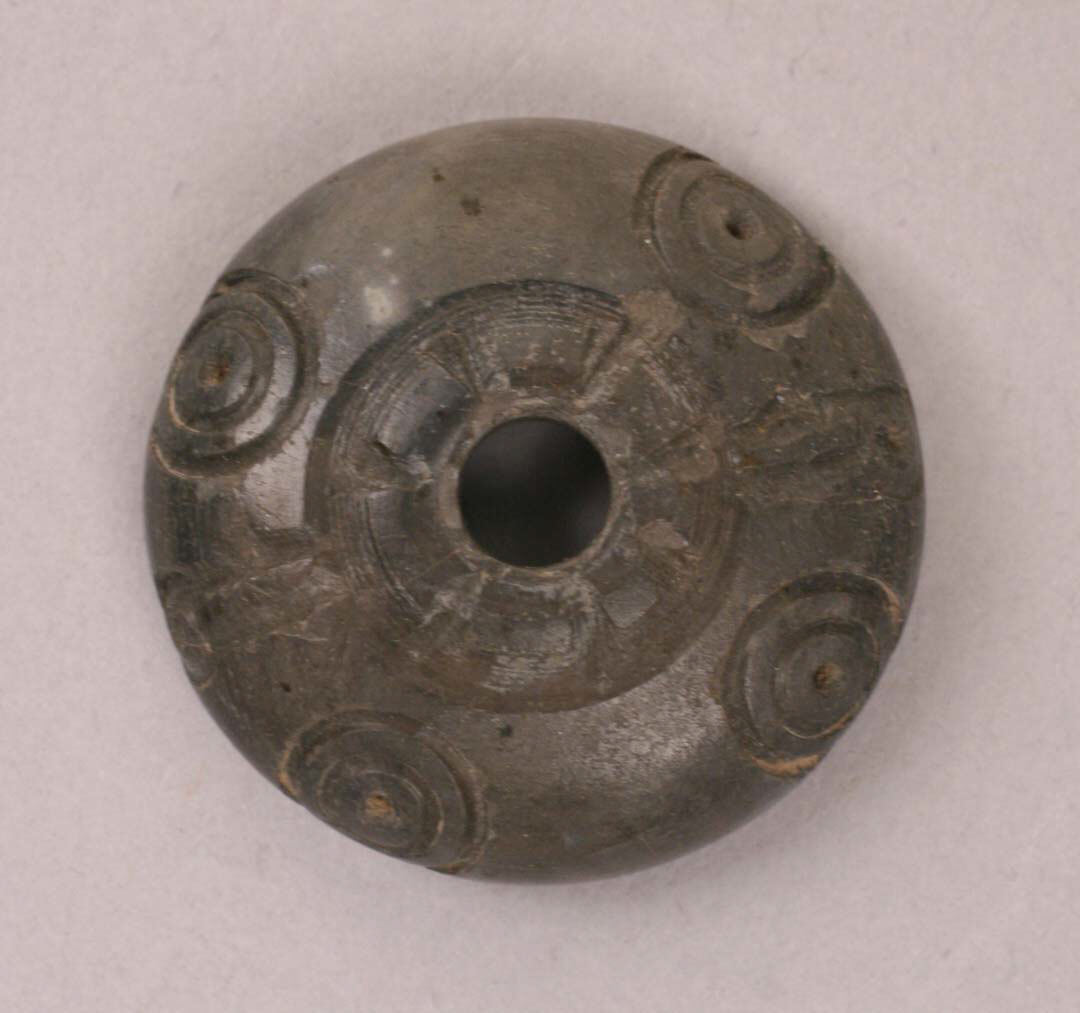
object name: button or bead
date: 801-1000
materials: bone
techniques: incising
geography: iran